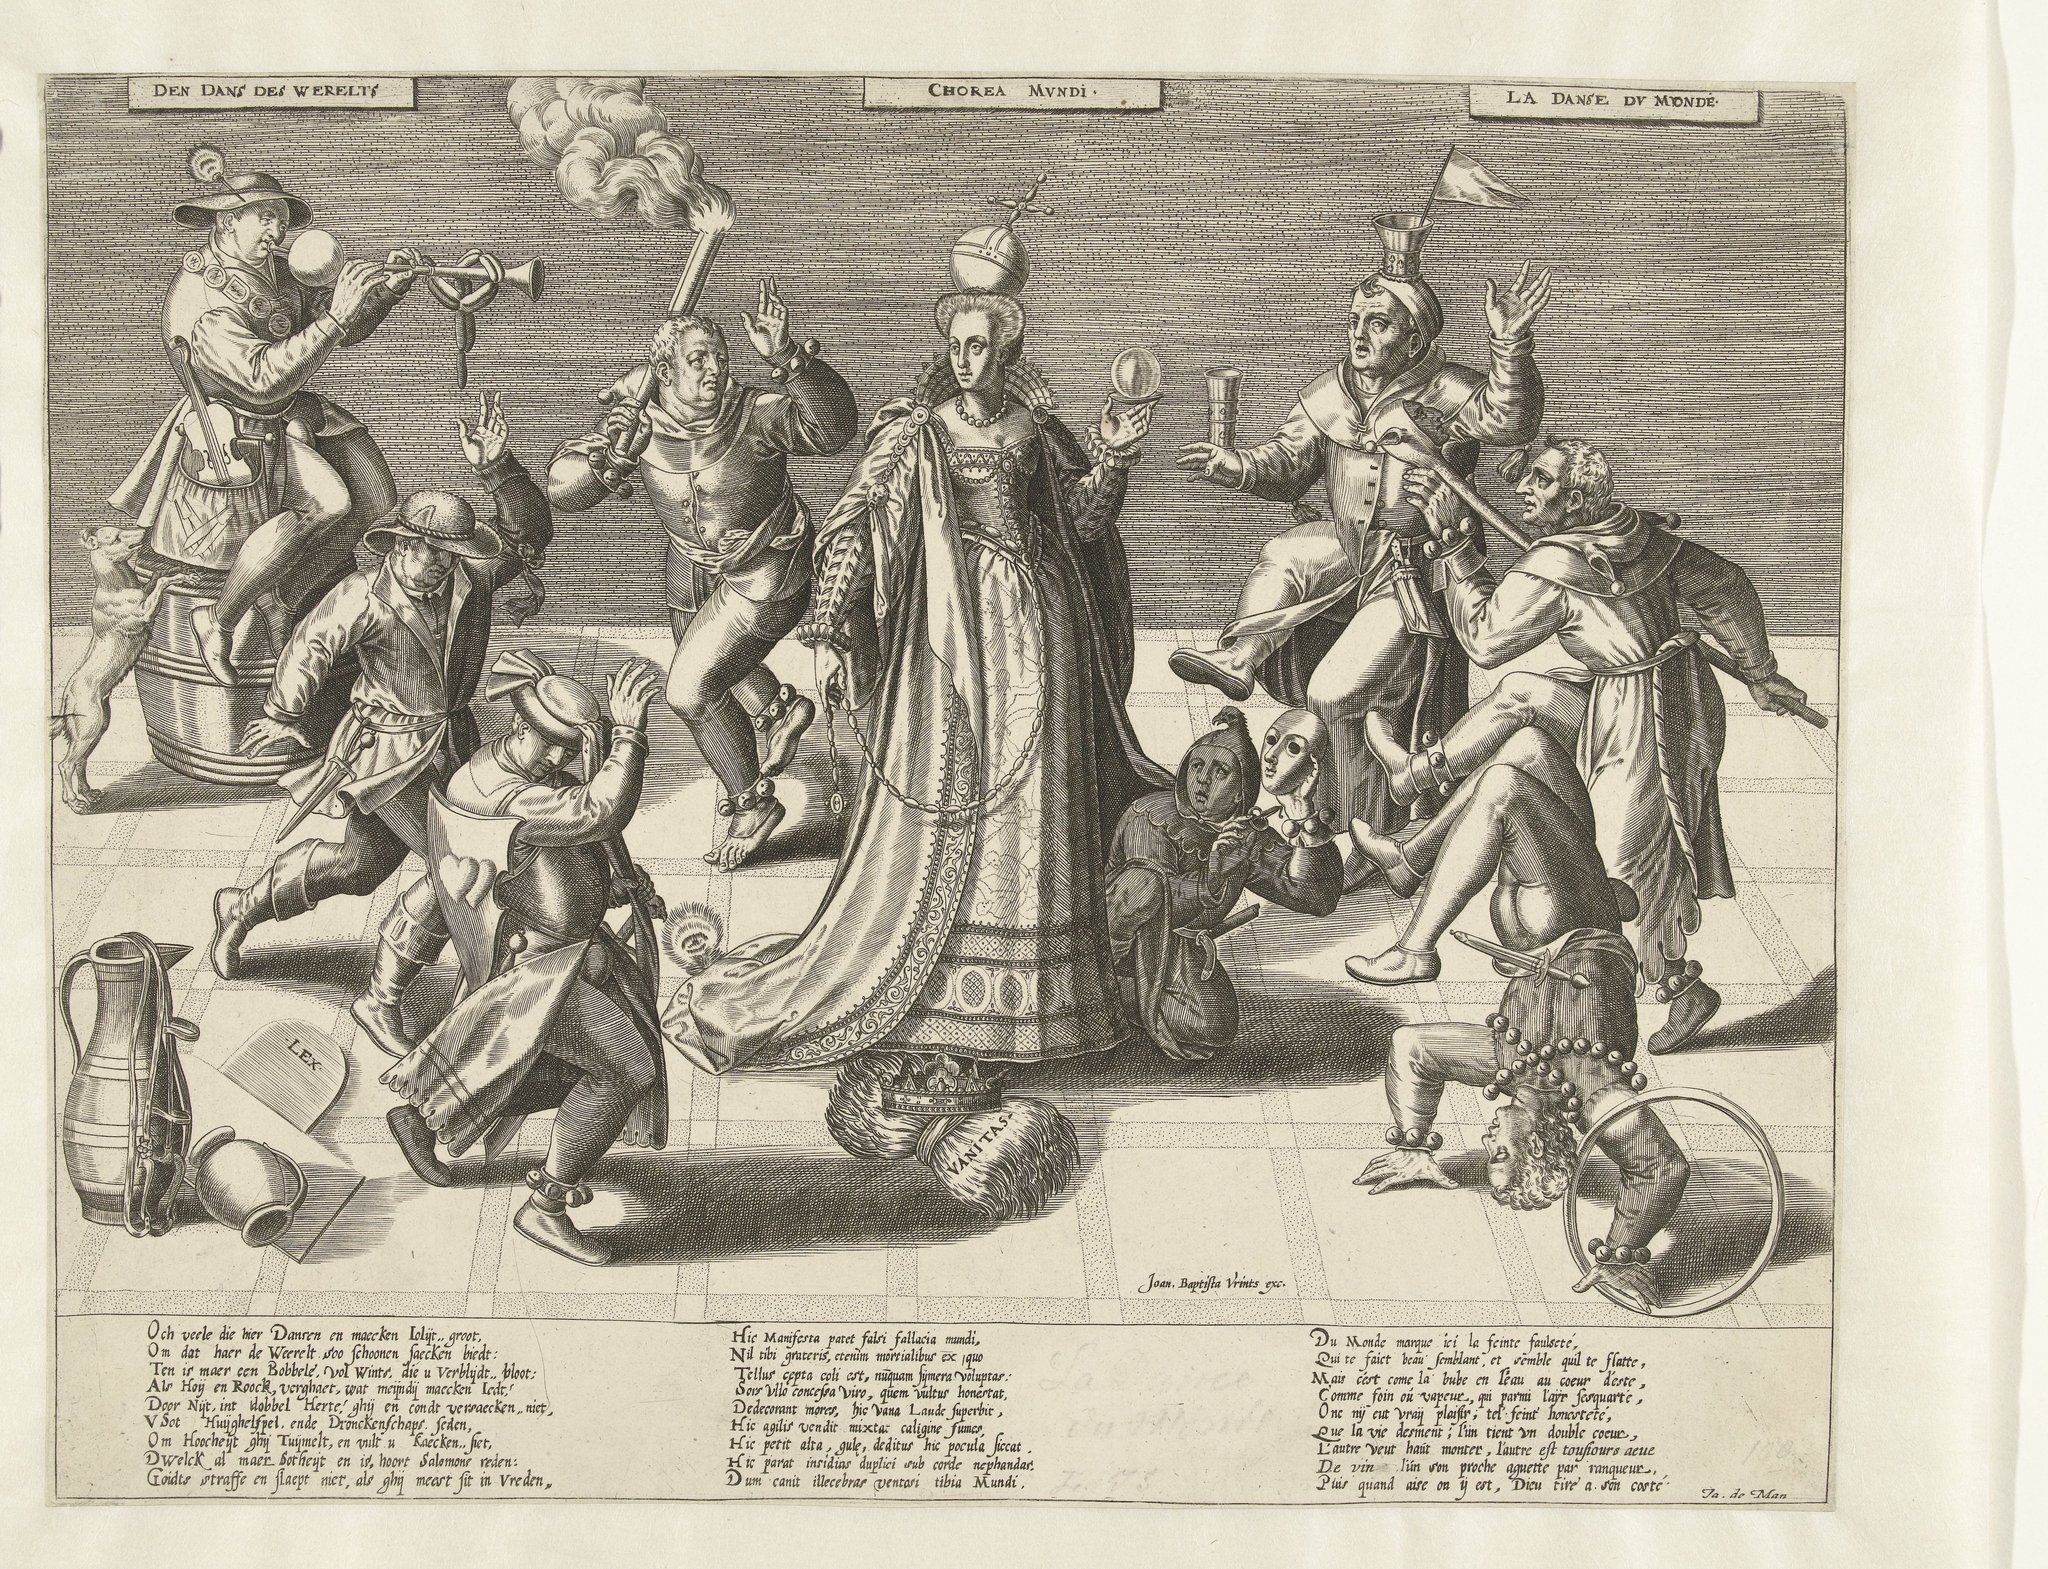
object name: print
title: Den Dans des Werelts / Chorea Mundi / La Danse du Monde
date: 1575-1624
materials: paper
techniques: engraving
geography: southern netherlands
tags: fool, simpleton, numskull, (personifications of) 'vanitas', the vanity of human life; fragilità humana, fugacità delle grandezze & della gloria mondana, meditatione della morte, opera vana, piacere vano, vana gloria, vanità (ripa), acrobat ~ circus, low countries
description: De dans om de wereld, ca. 1600. In het midden de rijk geklede Vrouwe Wereld, met een wereldbol op haar hoofd en een zeepbel in de hand, bij haar voeten een baal hooi met een kroon aangeduid als Vanitas. Onder haar mantel een nar met een masker in de hand. Om de vrouw heen dansen in een het rond zes mannen (waaronder een acrobaat en een priester) die dwaze wereldse eigenschappen personifiëren. Linksboven speelt een muzikant op een fluit. Symbolen van Matigheid en Gods wetten liggen links vooraan achteloos op de vloer. Met onderschrift van 3 verzen van elk 9 regels in het Nederlands, Latijn en Frans.